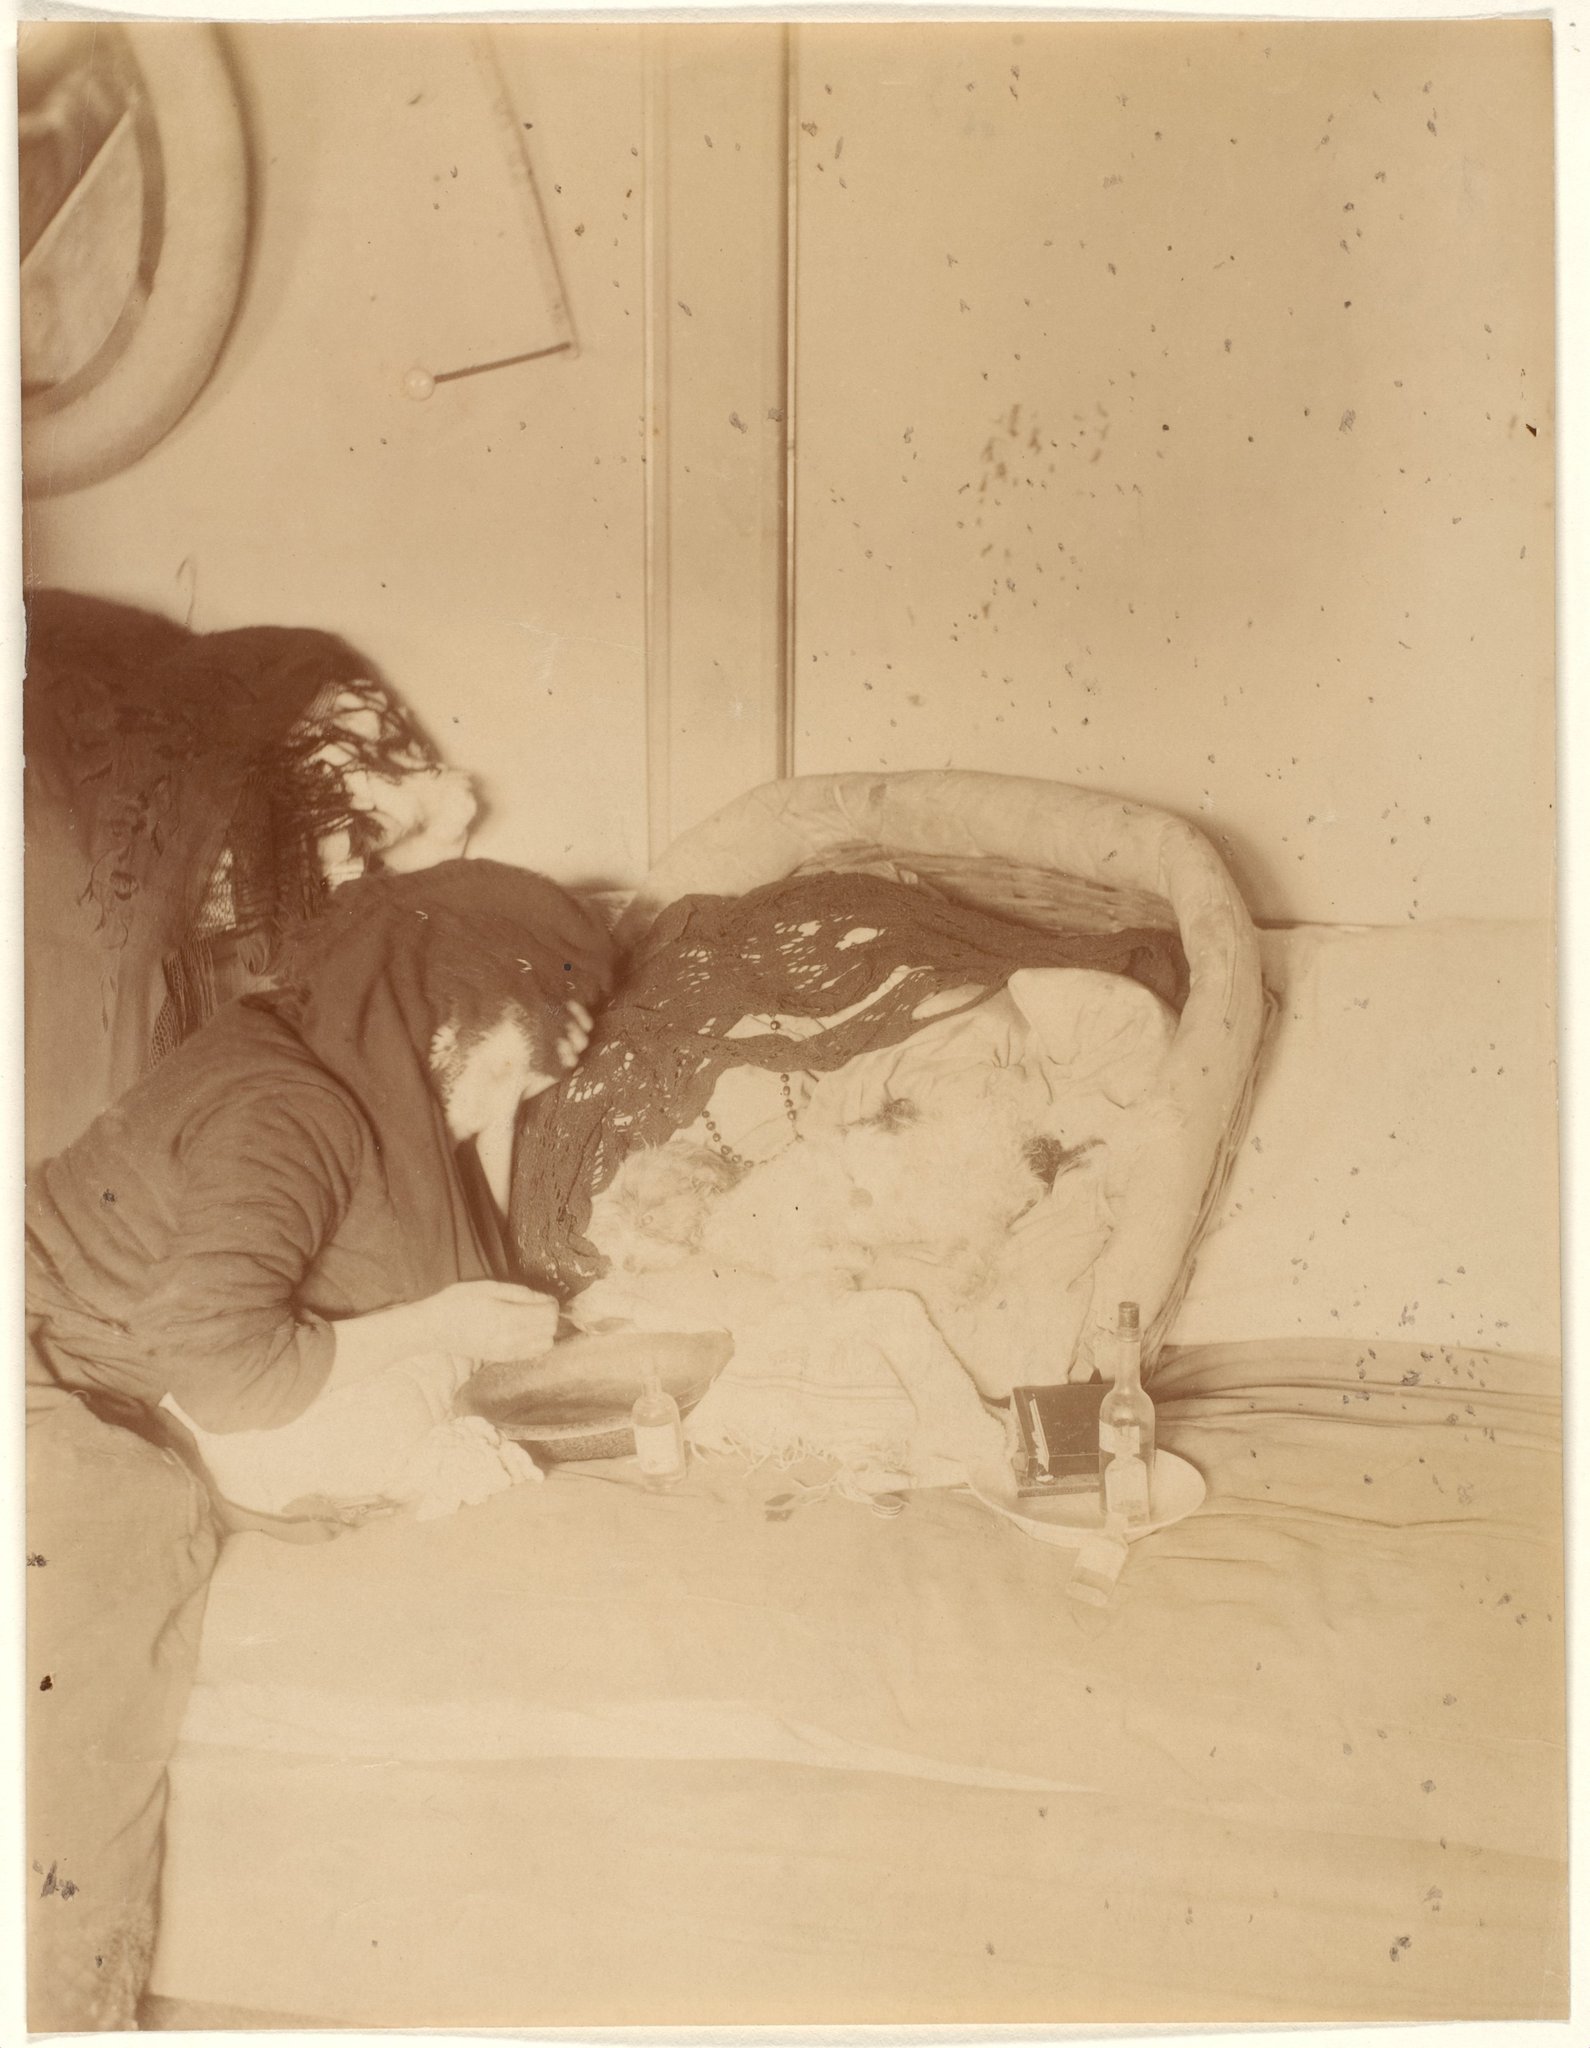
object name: photograph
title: Les Chiens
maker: pierre-louis pierson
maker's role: artist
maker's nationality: french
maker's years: 1822-1913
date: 1875-1880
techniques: albumen silver print, glass negative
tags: women,dogs